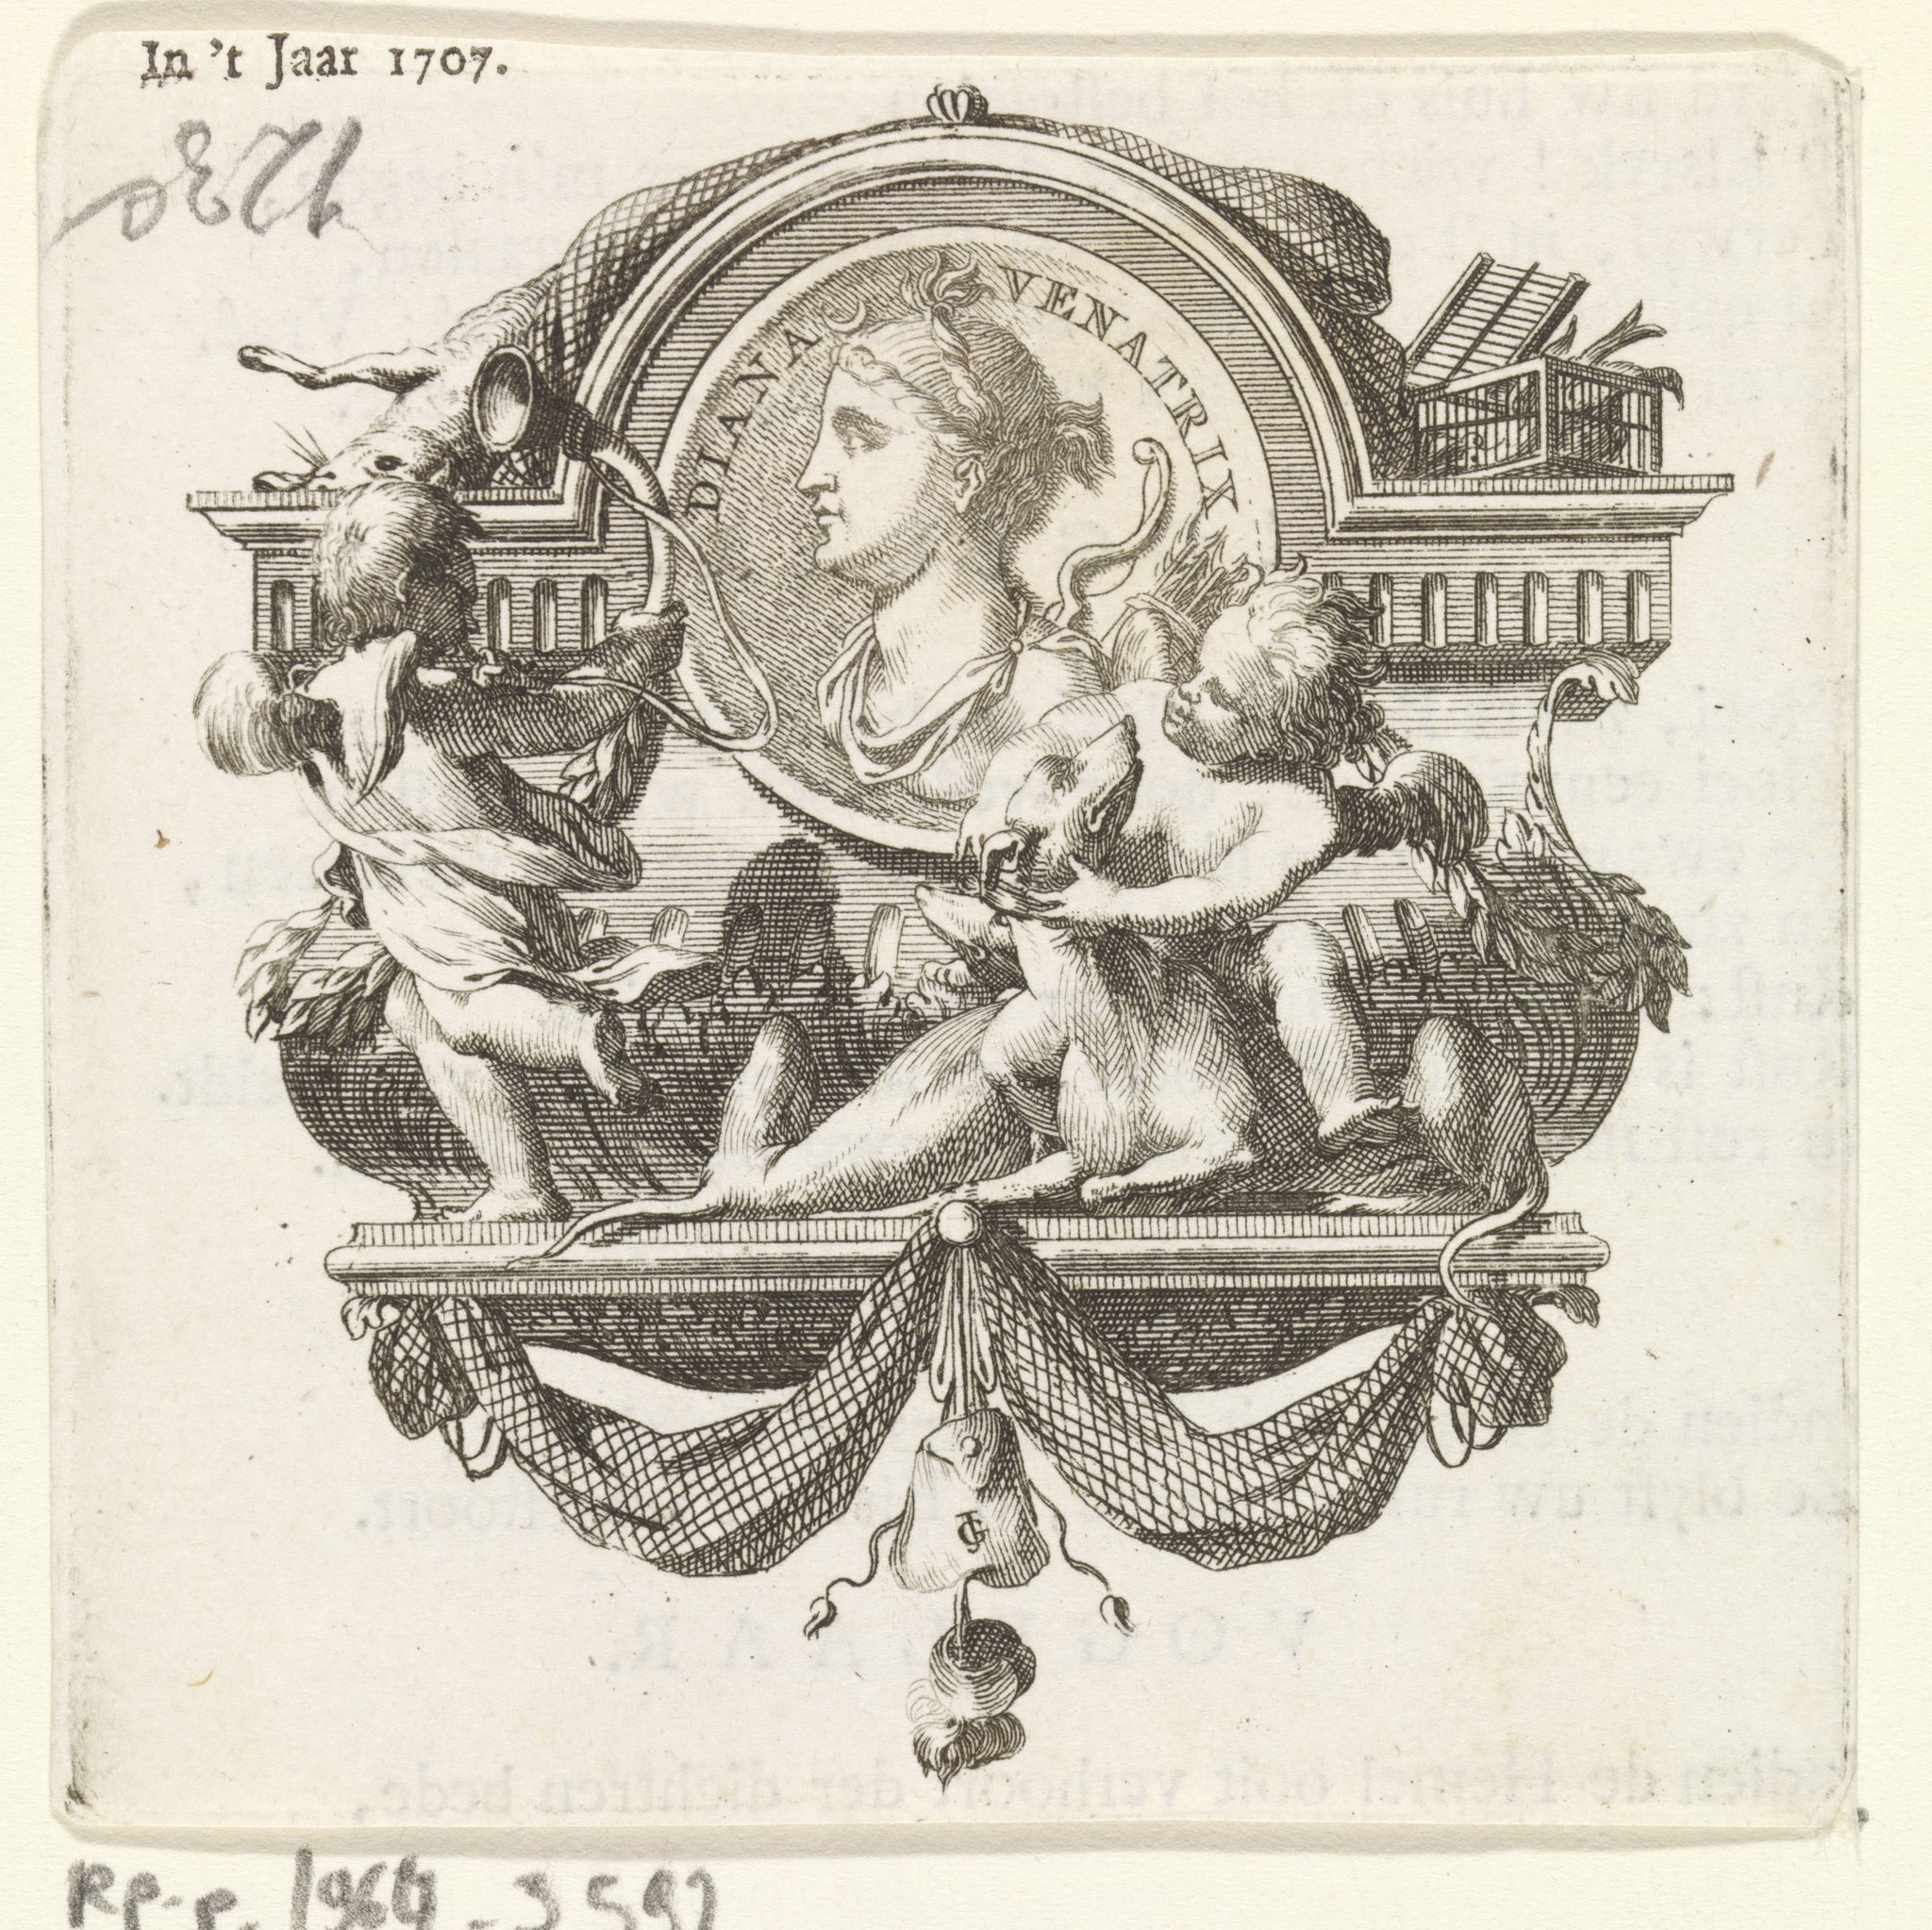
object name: book illustration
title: Portret van Diana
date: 1707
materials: paper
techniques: engraving, letterpress printing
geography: amsterdam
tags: (story of) diana (artemis), cupids: 'amores', 'amoretti', 'putti'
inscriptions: collector's mark: Lugt 2228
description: Boekillustratie voor Jan Baptista Wellekens and Pieter Vlaming, "Dichtlievende Uitspanningen". Amsterdam bij A. van Damme, 1710, p. 38.